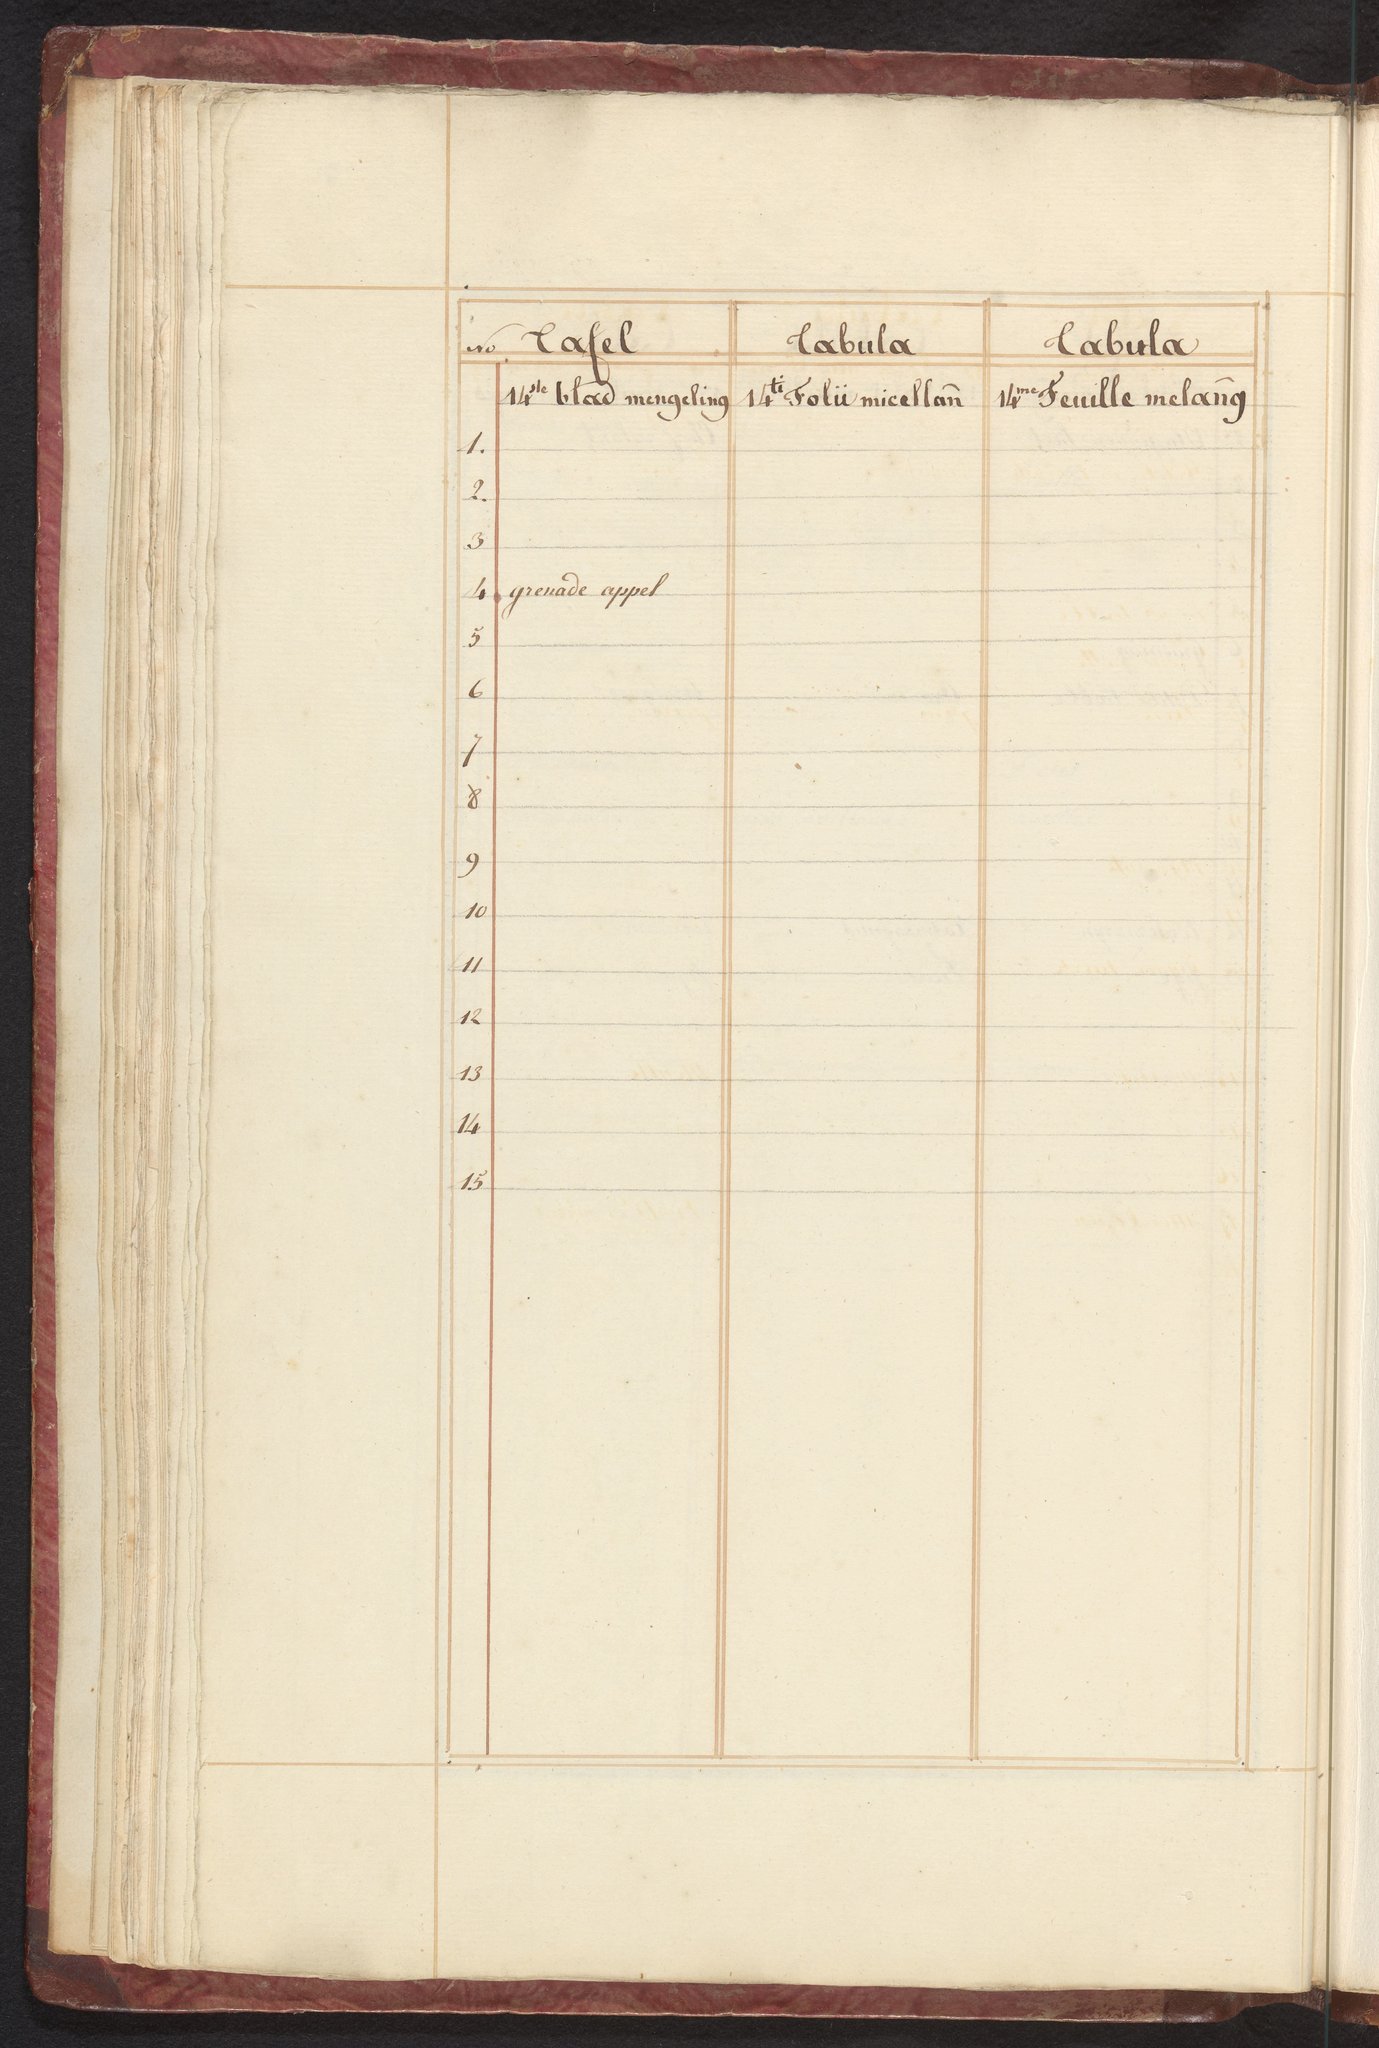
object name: manuscript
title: Lijst van dieren en planten in het veertiende ensemble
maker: joseph van huerne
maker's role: kunstliefhebber, mecenas, verzamelaar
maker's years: 1752-1844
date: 1809-1814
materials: ink, paper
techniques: handwriting, pen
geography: bruges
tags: handwriting, written text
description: Schema met een lijst in drie kolommen van de dieren en planten afgebeeld in het veertiende ensemble, nummers 1-15. Onderdeel van het zevende album met tekeningen van reptielen, amfibieën en natuurhistorische ensembles. Het zevende van twaalf albums met aquarellen van dieren, vogels en planten bekend rond 1600, gemaakt in opdracht van keizer Rudolf II. Met toelichting in Nederlands, Latijn en Frans.